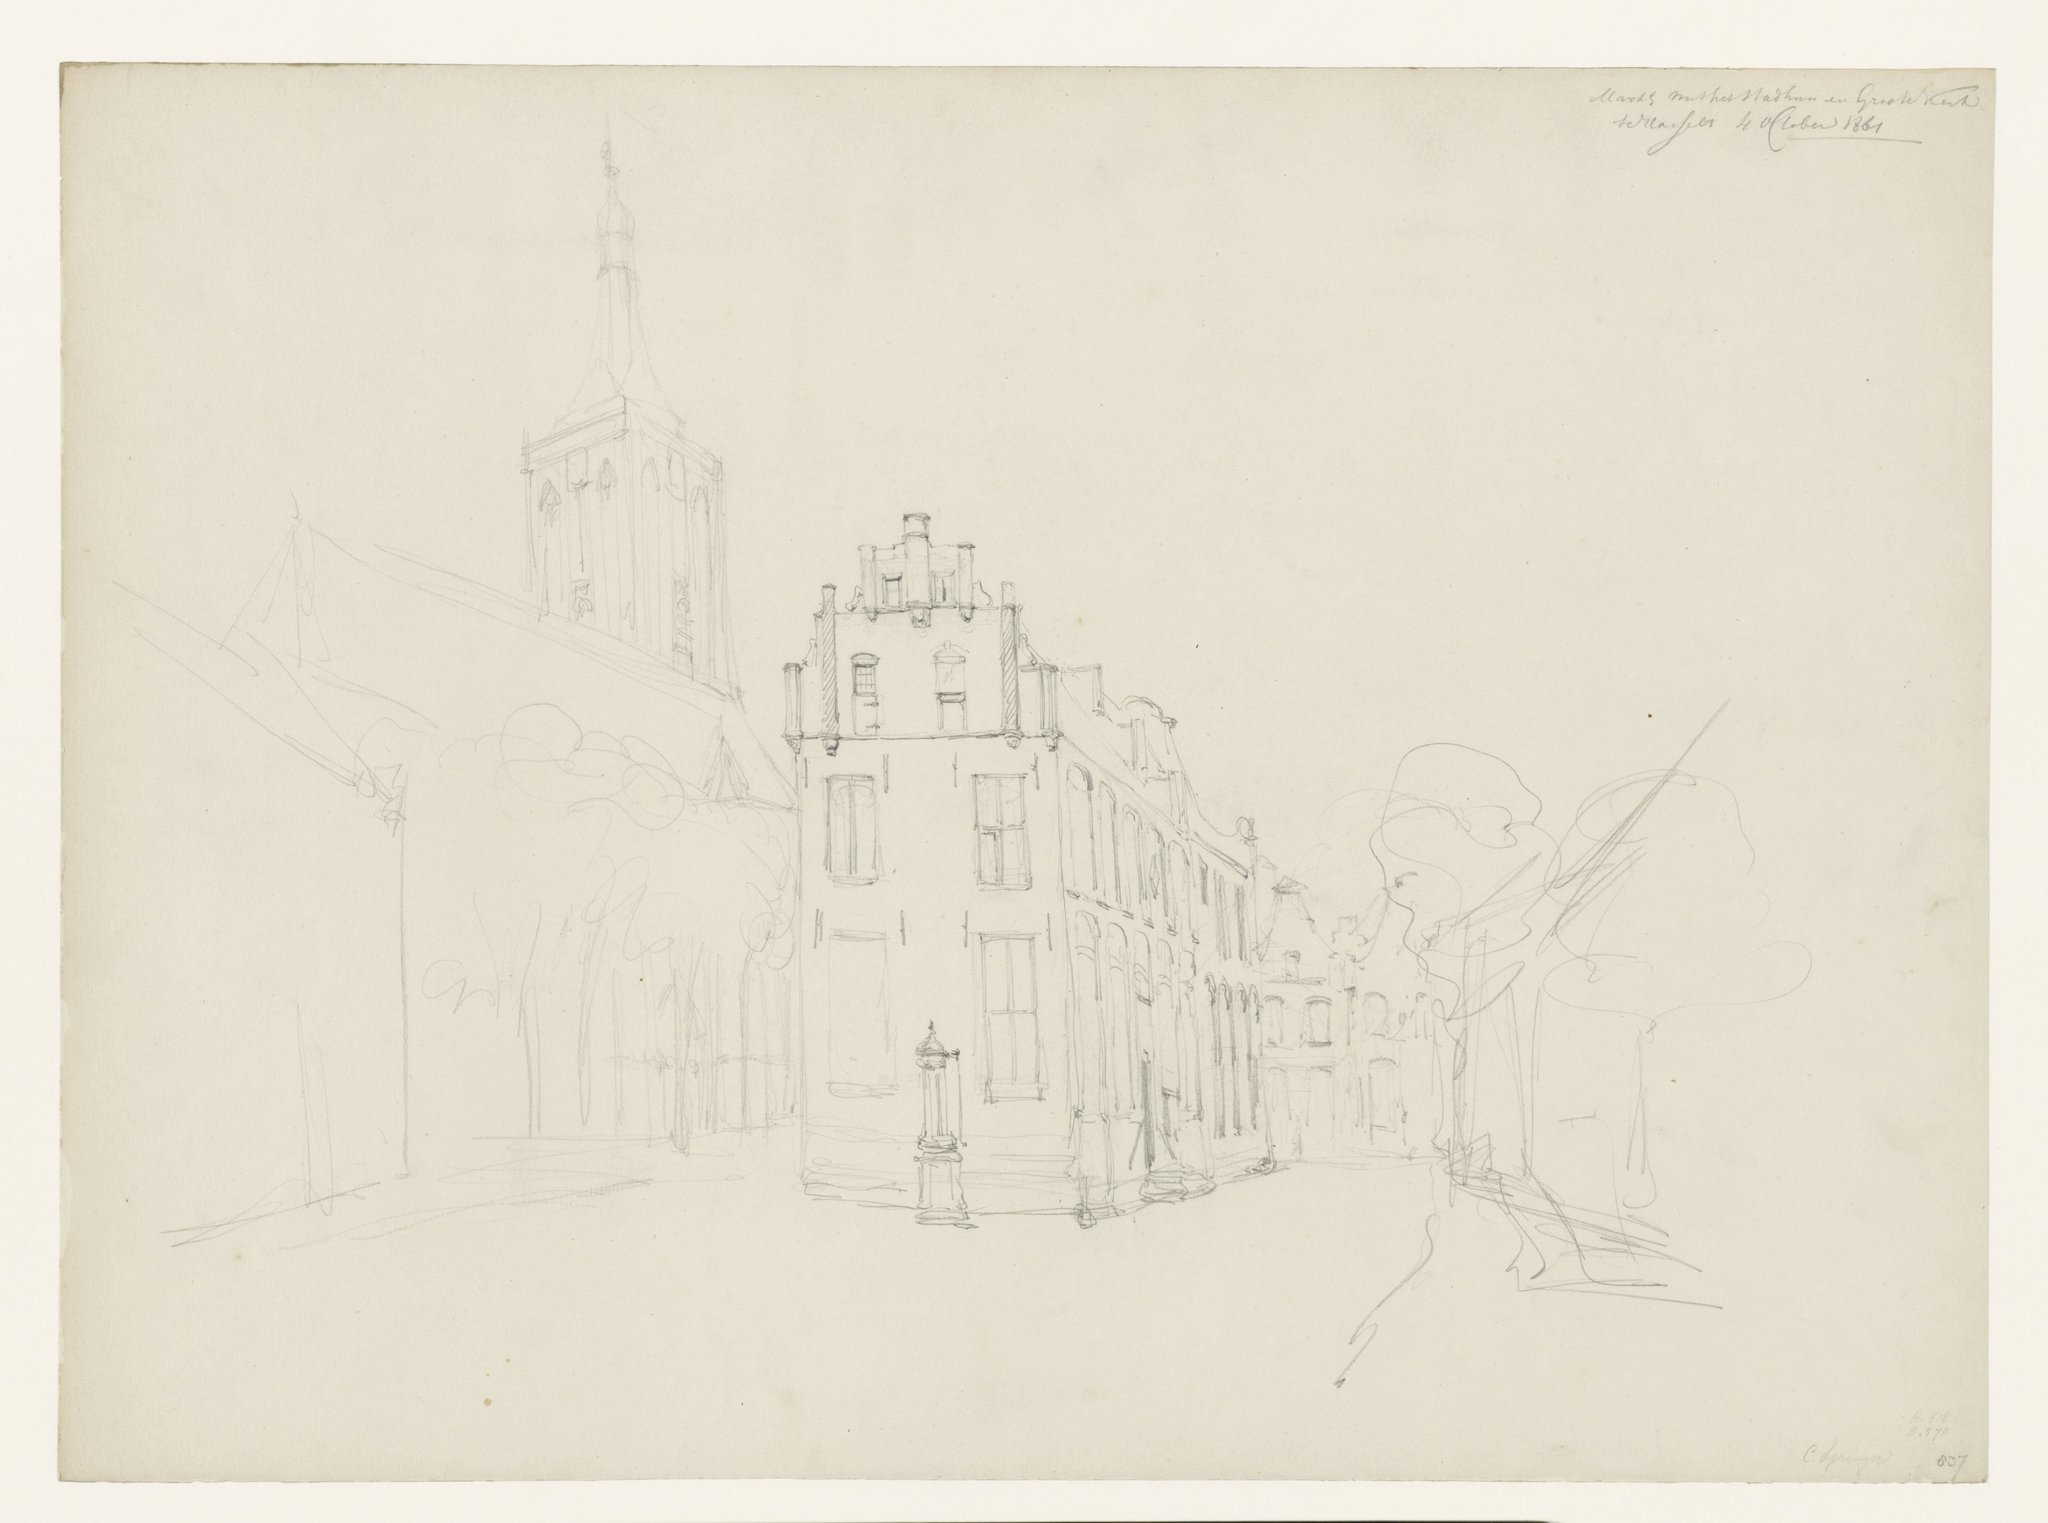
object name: drawing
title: Het Stadhuis en de Grote Kerk te Hasselt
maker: cornelis springer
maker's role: draughtsman, painter, print maker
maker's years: 1817-1891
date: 1861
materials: paper, pencil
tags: church (exterior), townhall, public road